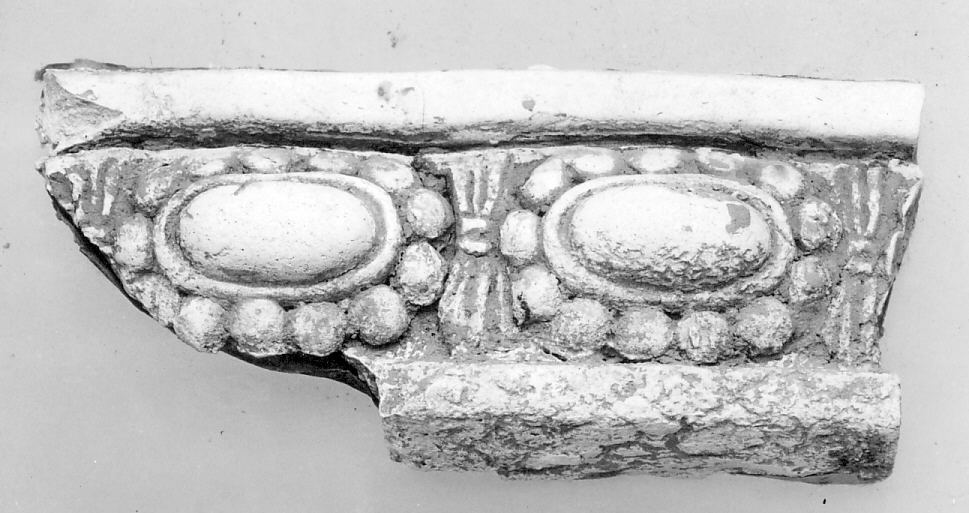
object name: relief fragment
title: Fragment of a Relief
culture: central asian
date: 601-800